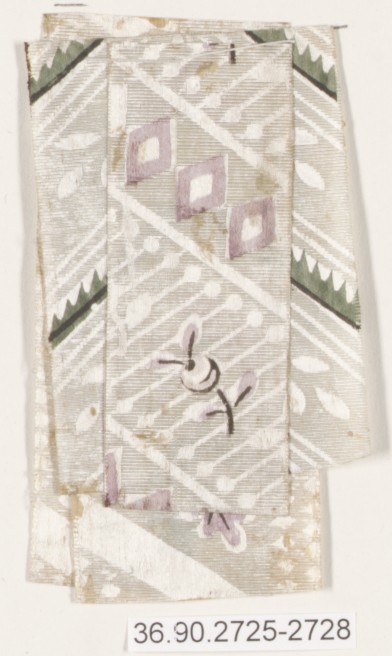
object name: ribbon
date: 1801-1900